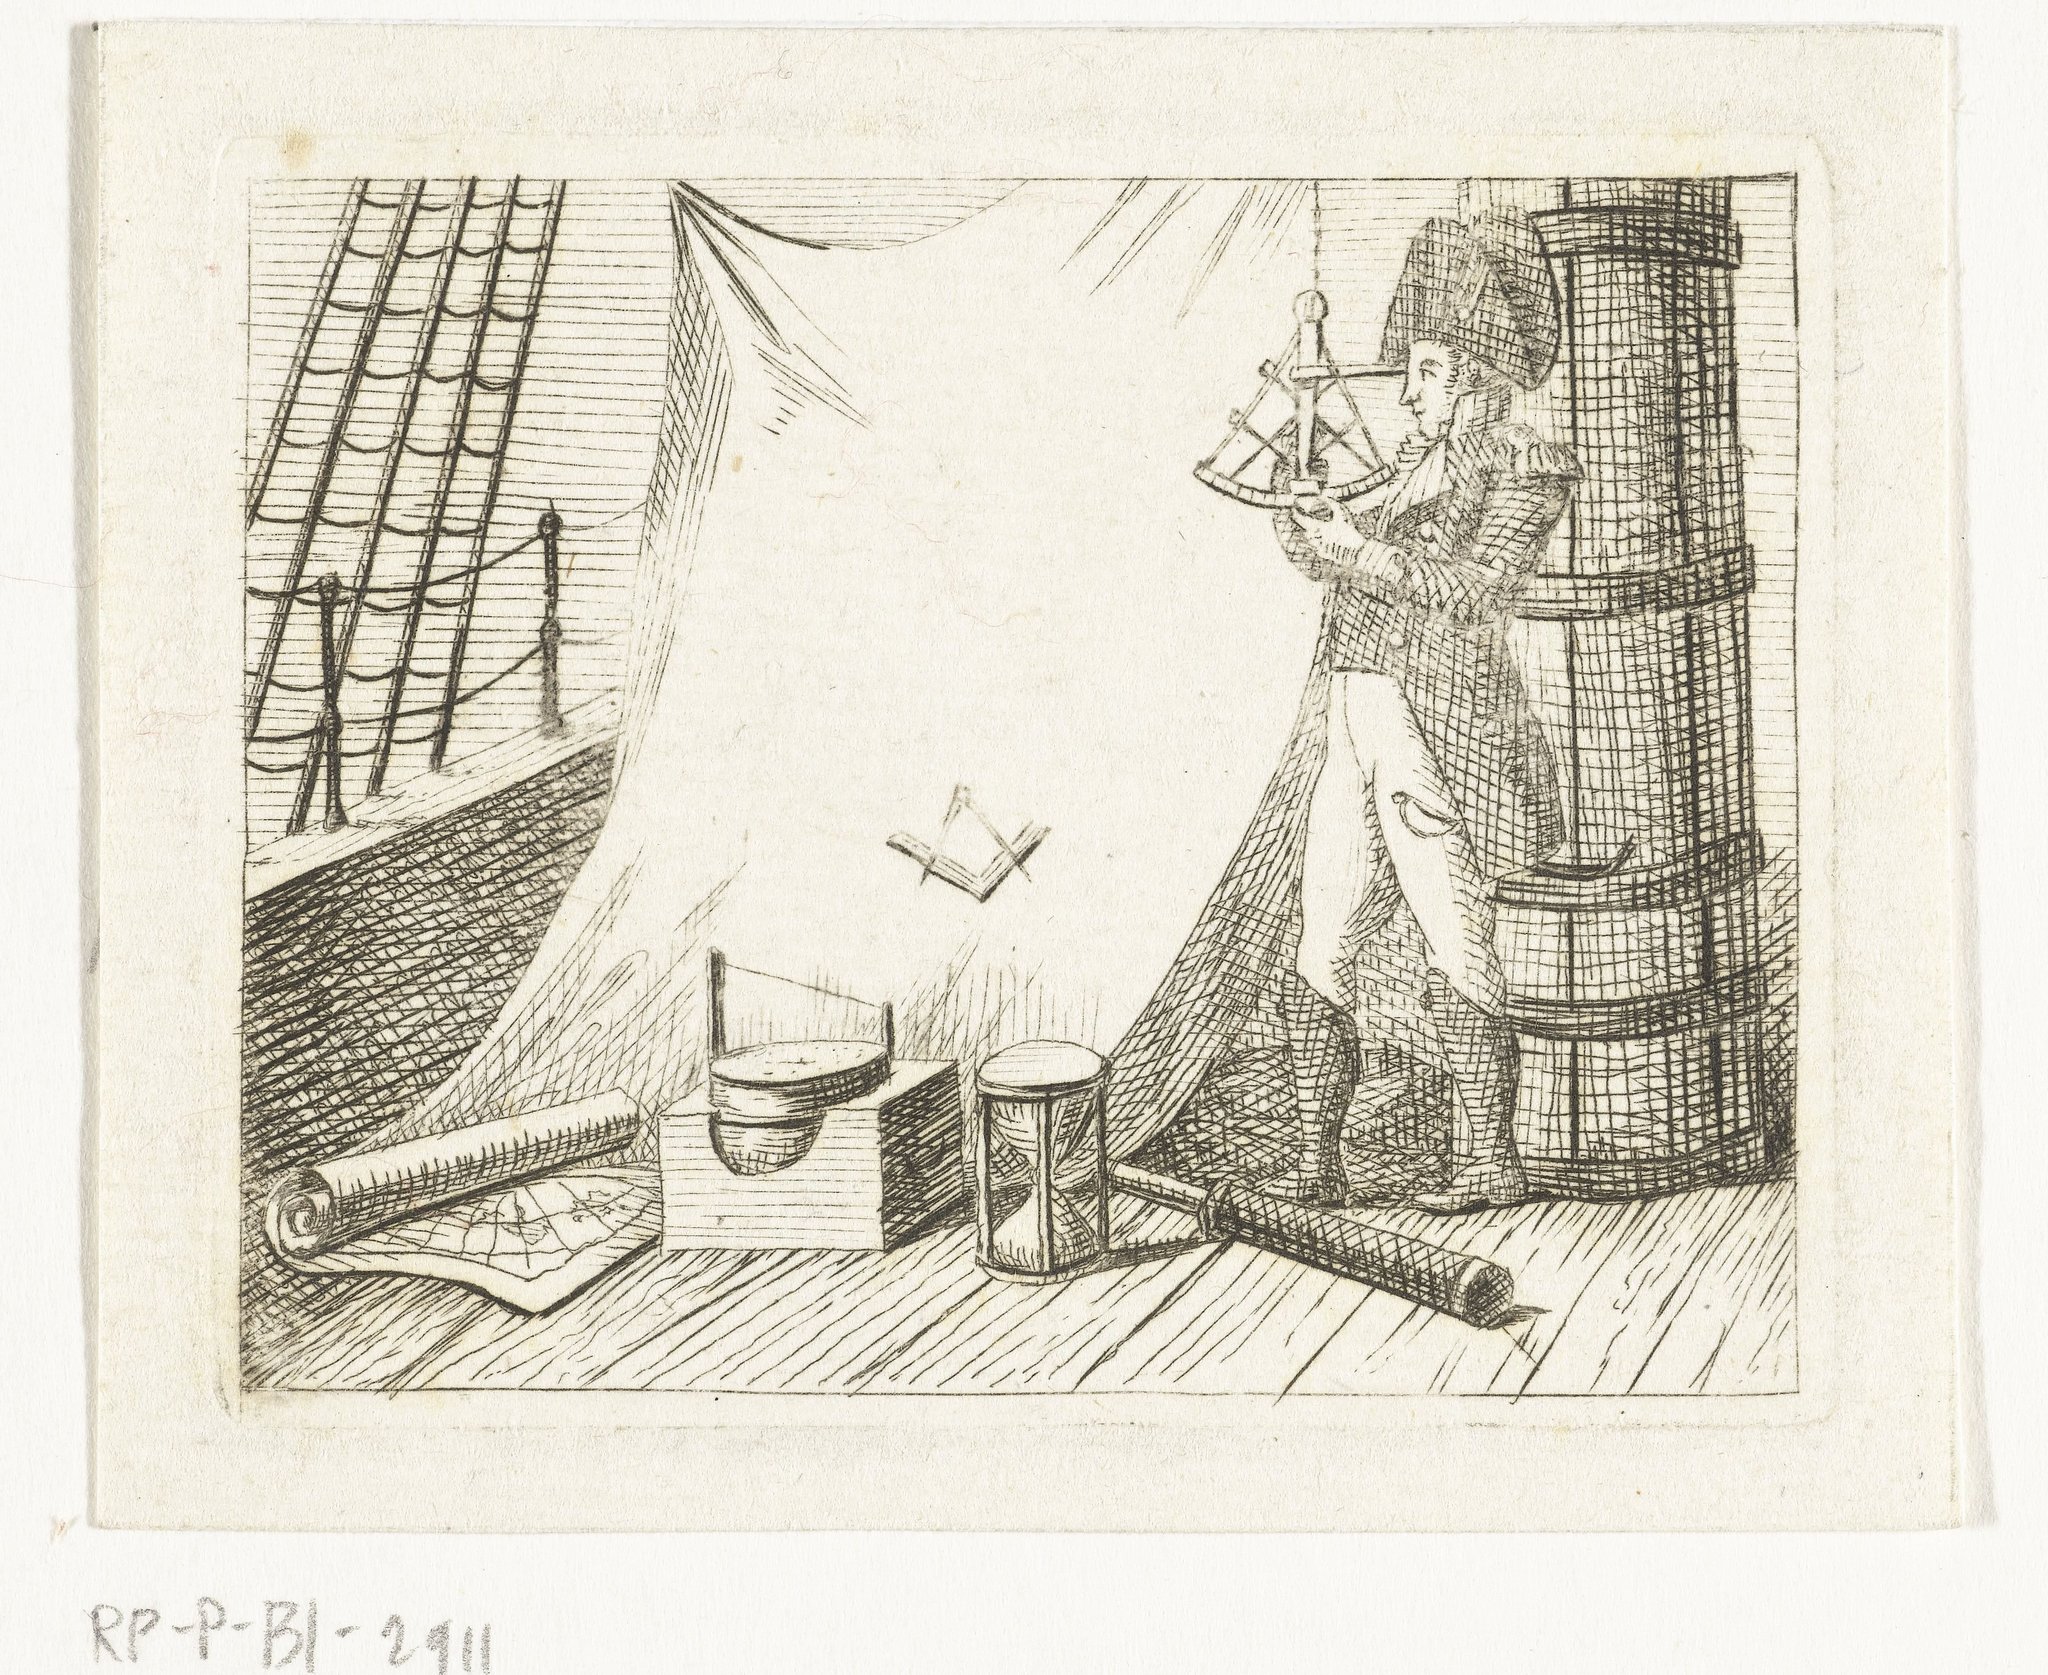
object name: print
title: Officier aan dek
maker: anthonie van den bos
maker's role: draughtsman, print maker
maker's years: 1763-1838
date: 1778-1838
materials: paper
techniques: etching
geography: amsterdam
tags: position-finding at sea; nautical instruments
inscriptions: collector's mark: Lugt 2228